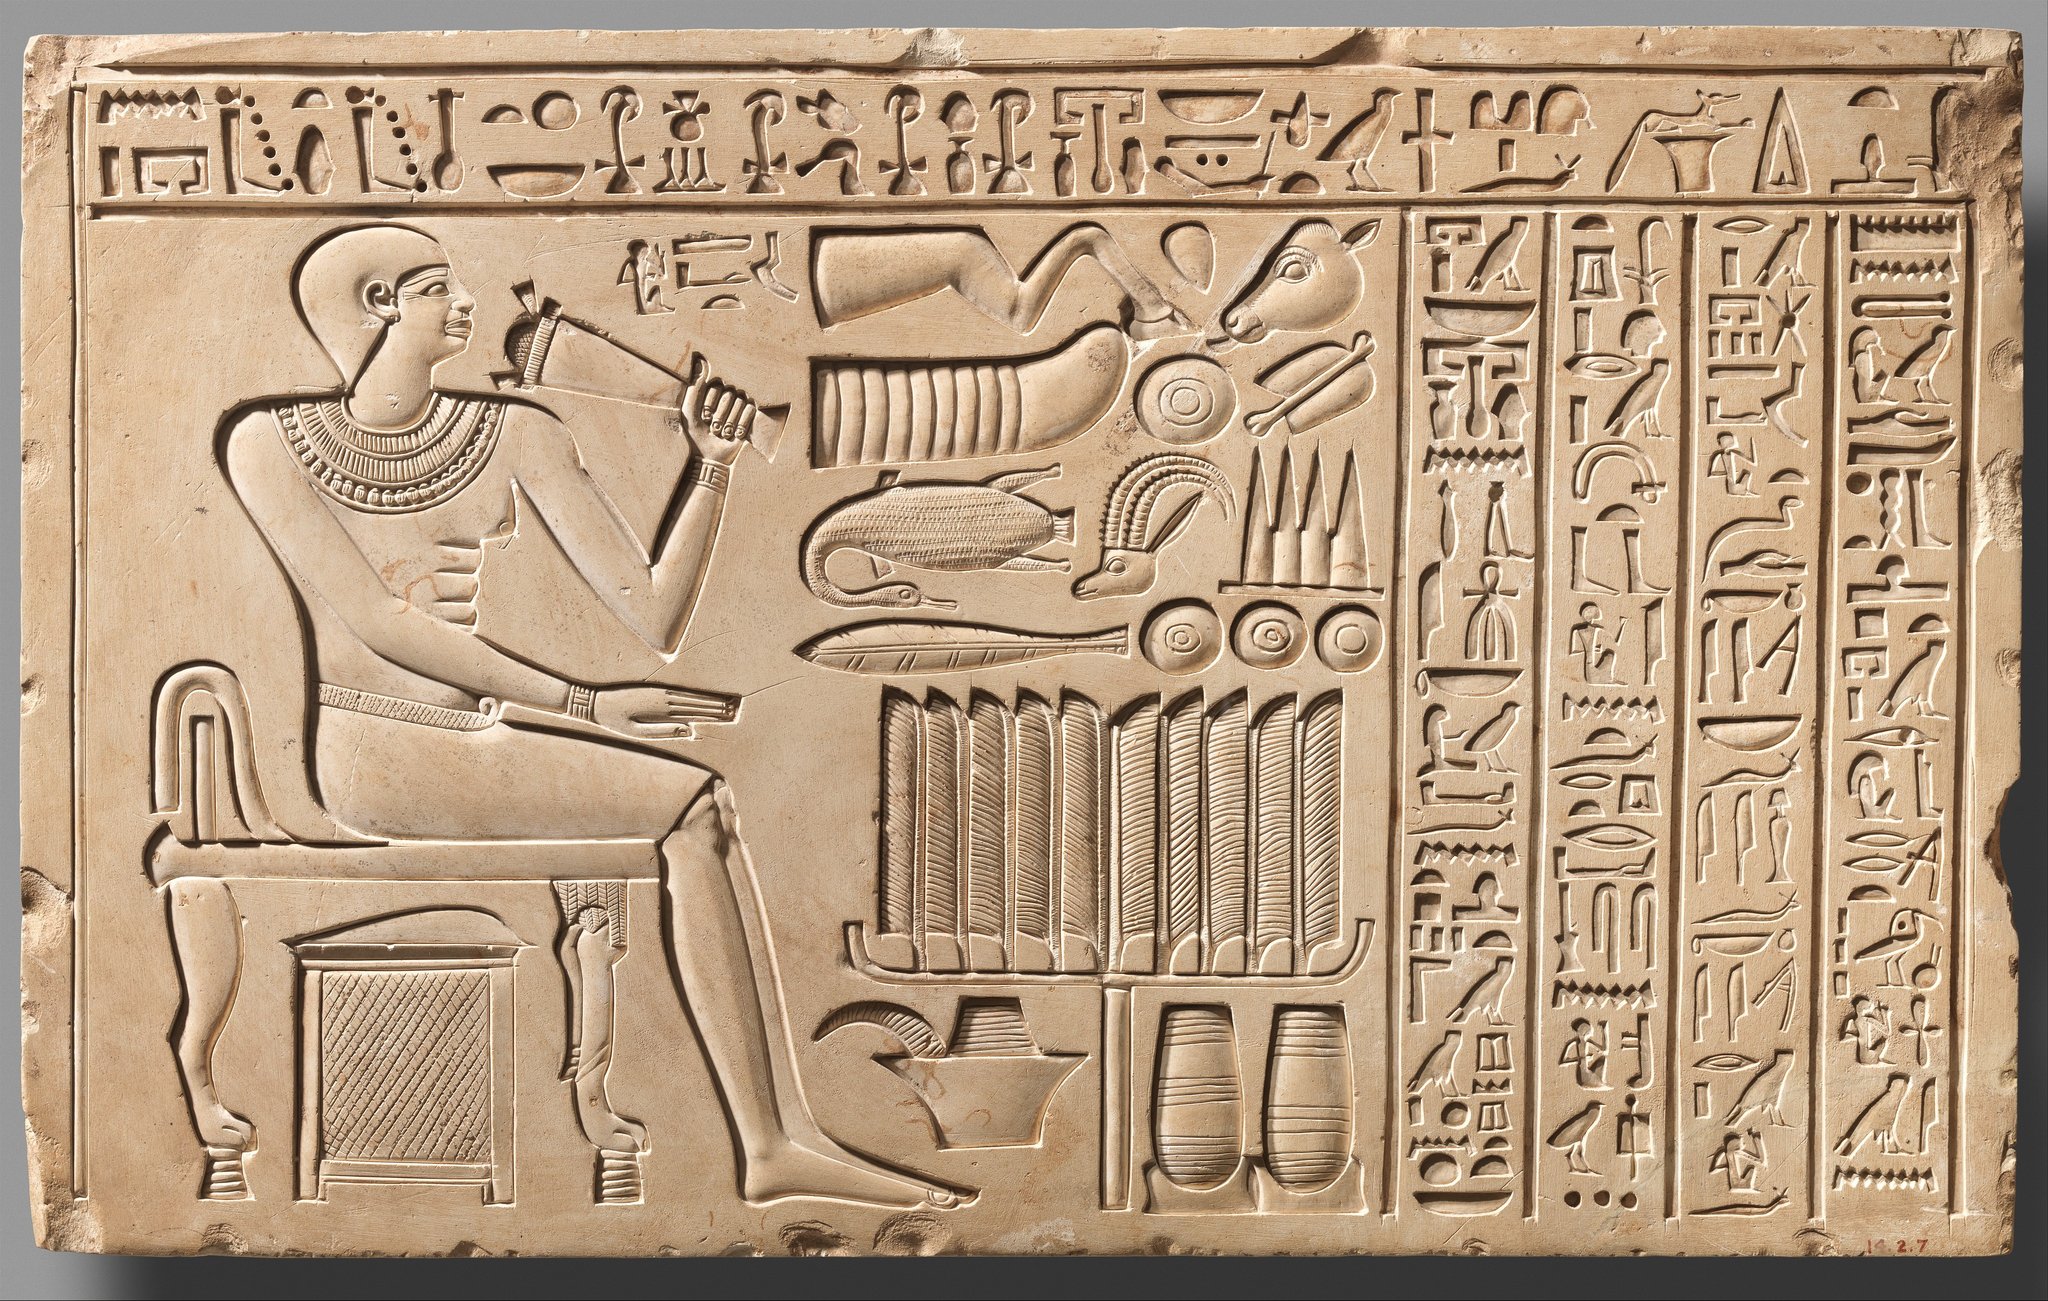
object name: stela, maati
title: Stela of the Gatekeeper Maati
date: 2051-2030 BCE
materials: limestone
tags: food,men,hieroglyphs